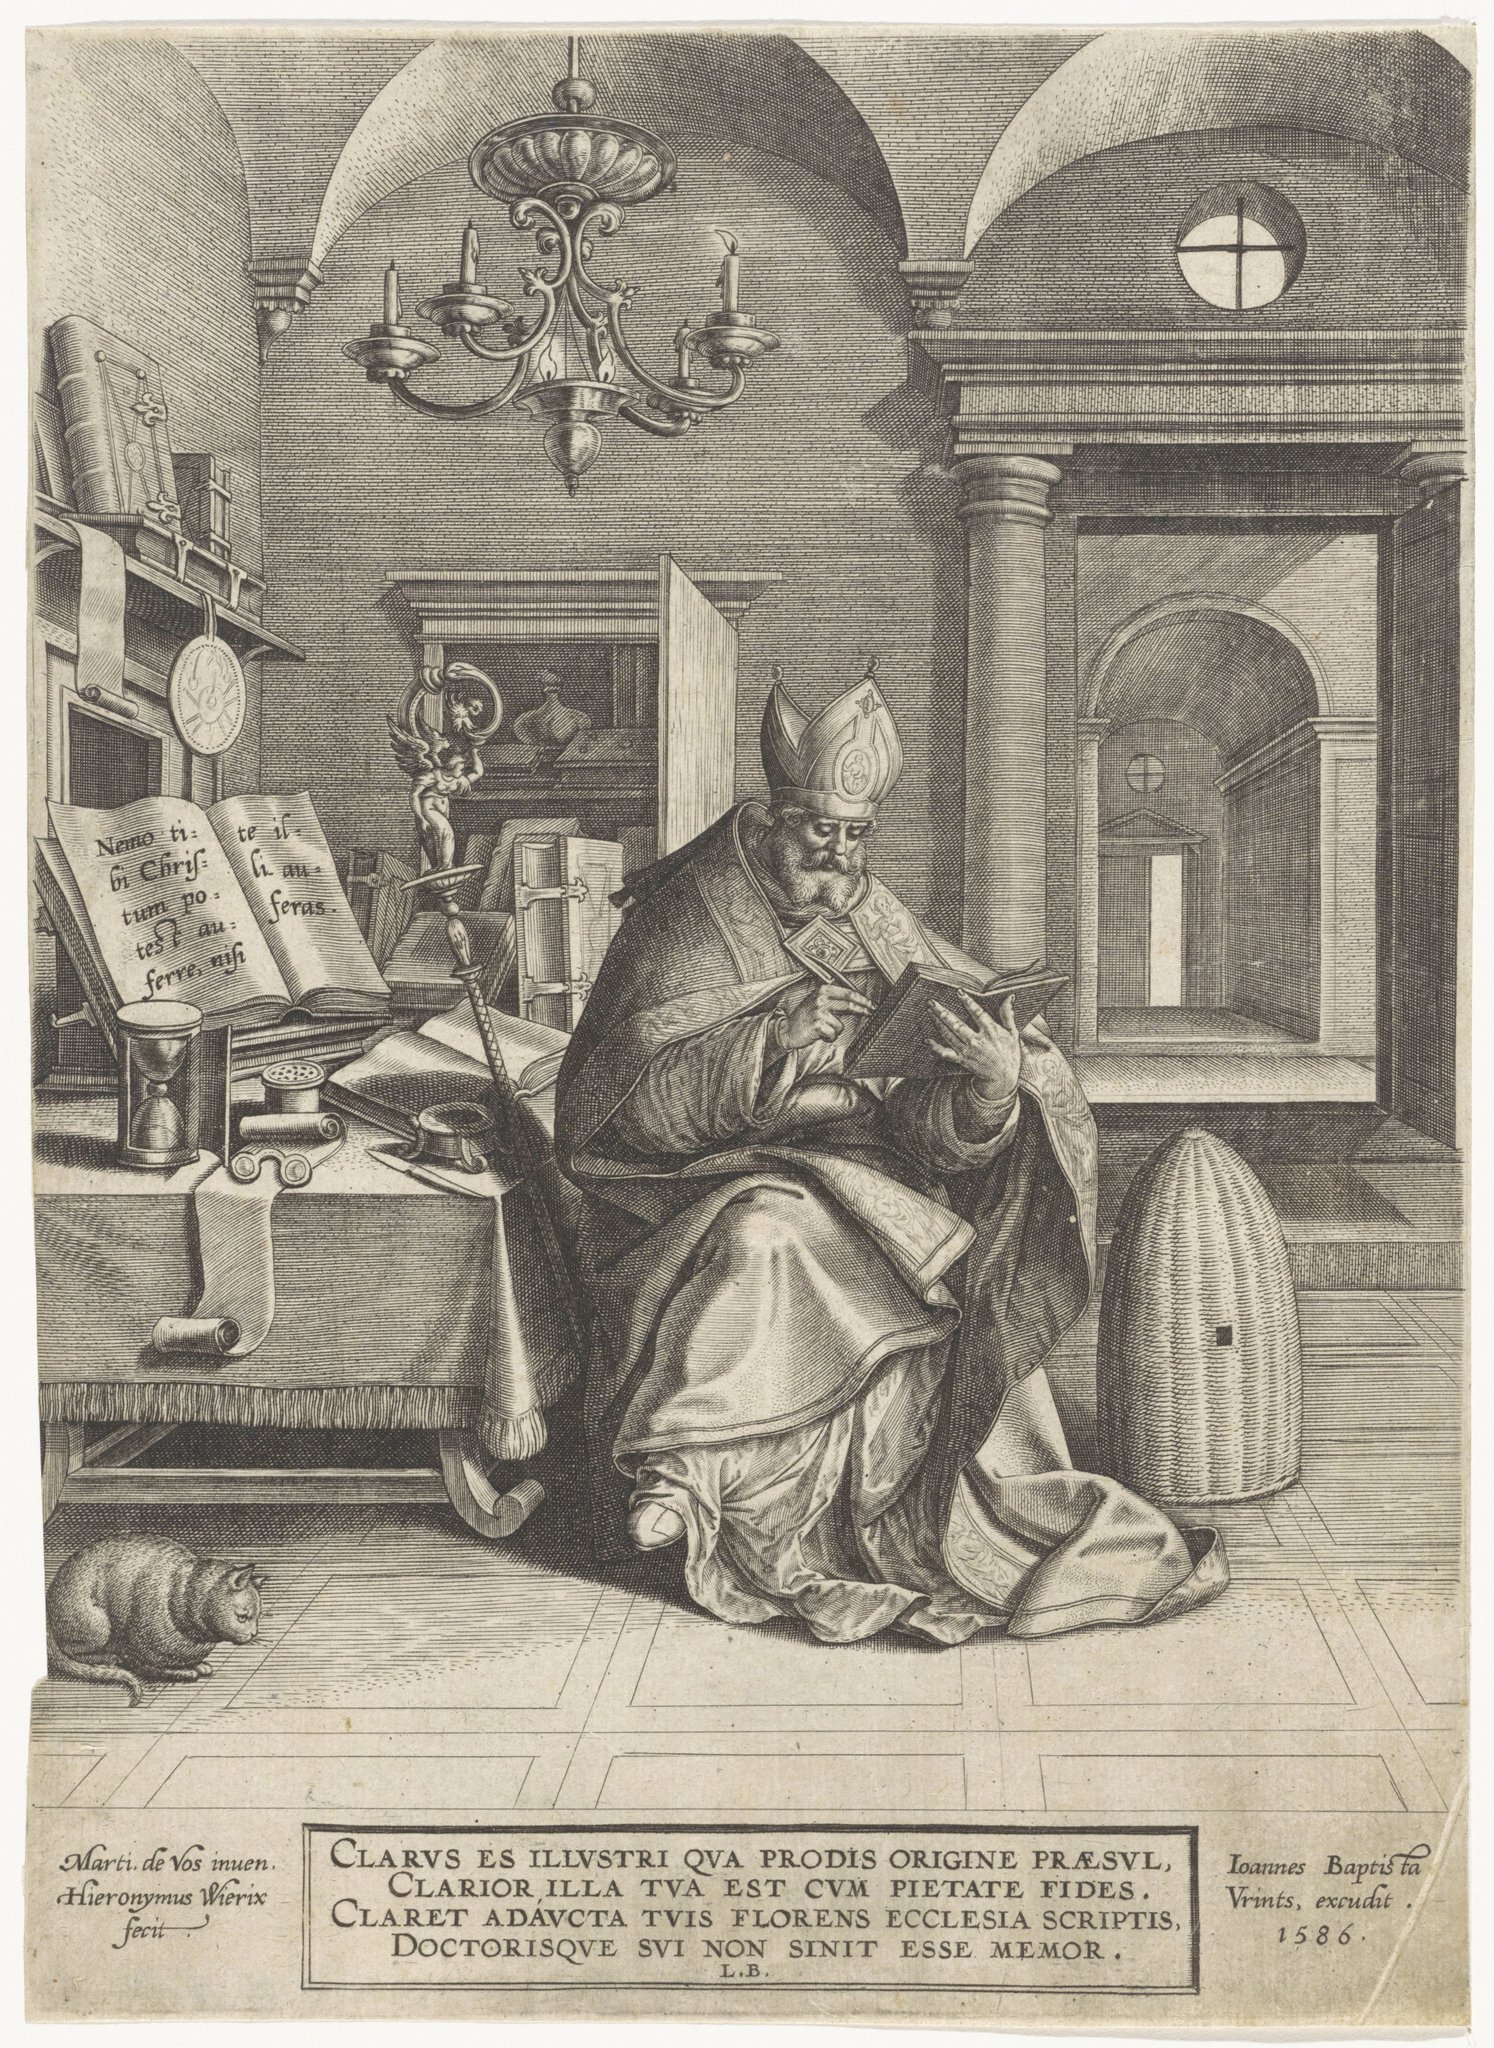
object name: print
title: Kerkvader Ambrosius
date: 1586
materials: paper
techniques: engraving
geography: antwerp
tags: cat, study; 'studiolo'; library, bee-hive, lighting; lamps, st. ambrose as doctor of the latin church in his study at his writing desk with book, pen and sometimes a dove (divine inspiration)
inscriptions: collector's mark: Lugt 2228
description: De H. Ambrosius zit in zijn studeervertrek een boek te lezen. Hij draagt zijn bisschopsmantel. Op de tafel opengeslagen boeken, schrijfgerei en een zandloper. Naast hem staat de bijenkorf, een verwijzing naar de zwerm bijen die in zijn mond ging zitten toen hij in de wieg lag. Op de voorgrond ligt een kat. In het kader in de marge een vierregelig onderschrift in het Latijn.